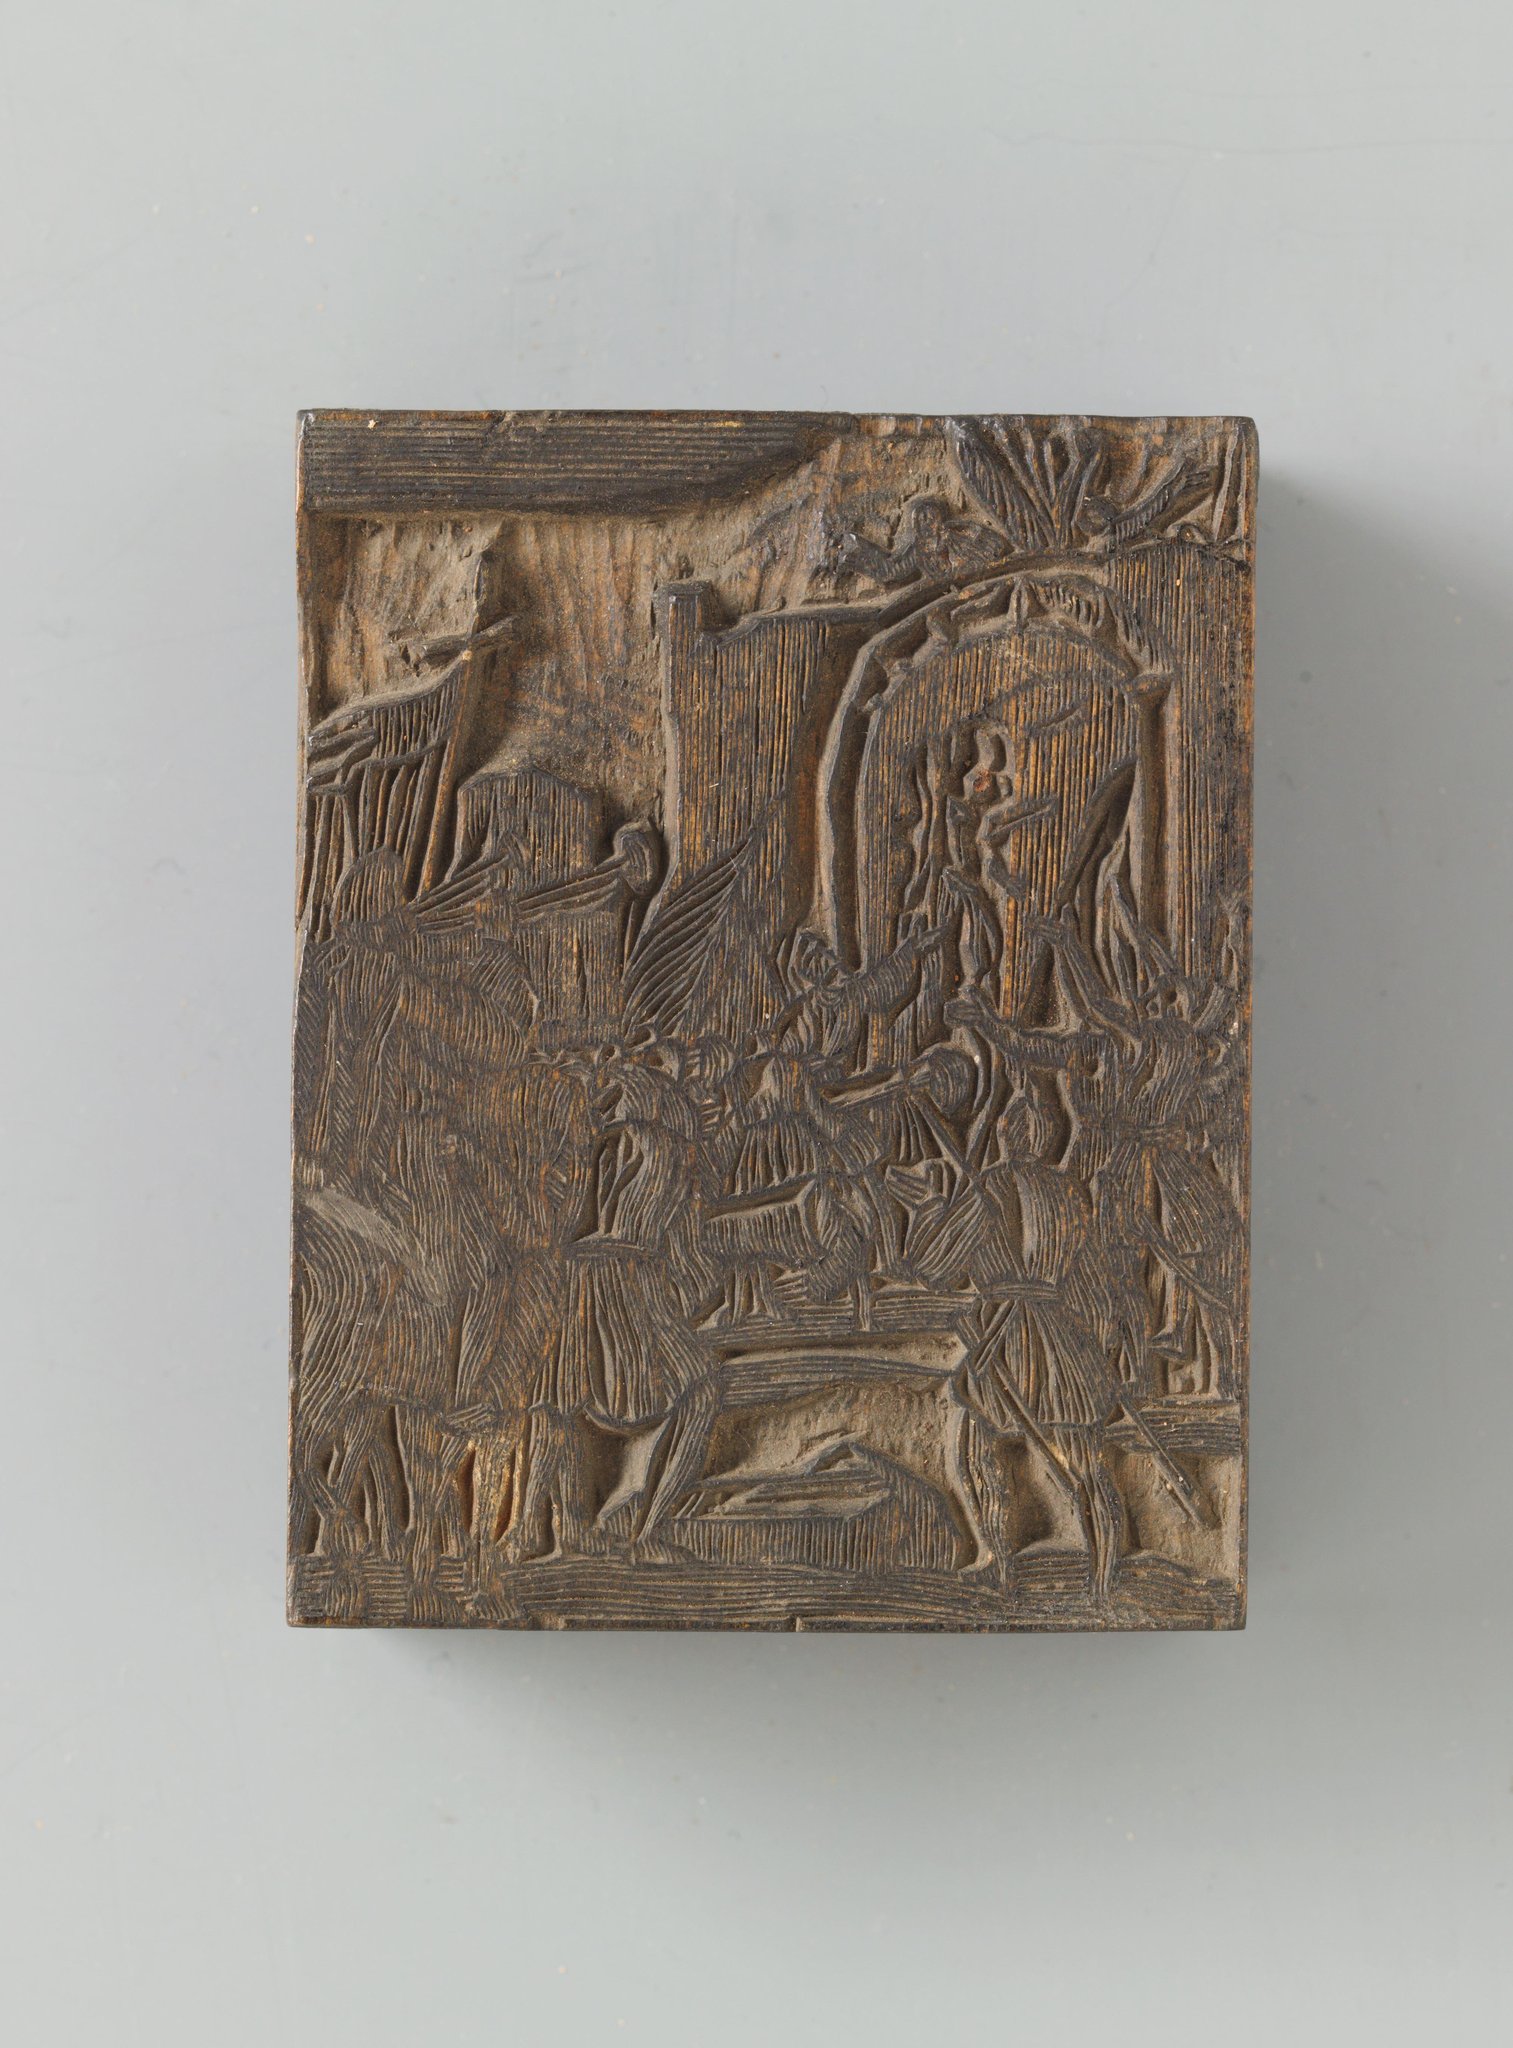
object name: wood block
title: Scénes: Mensen in middeleeuwse kleding voor een poort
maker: Anonymous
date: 1700-1899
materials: wood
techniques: woodcut